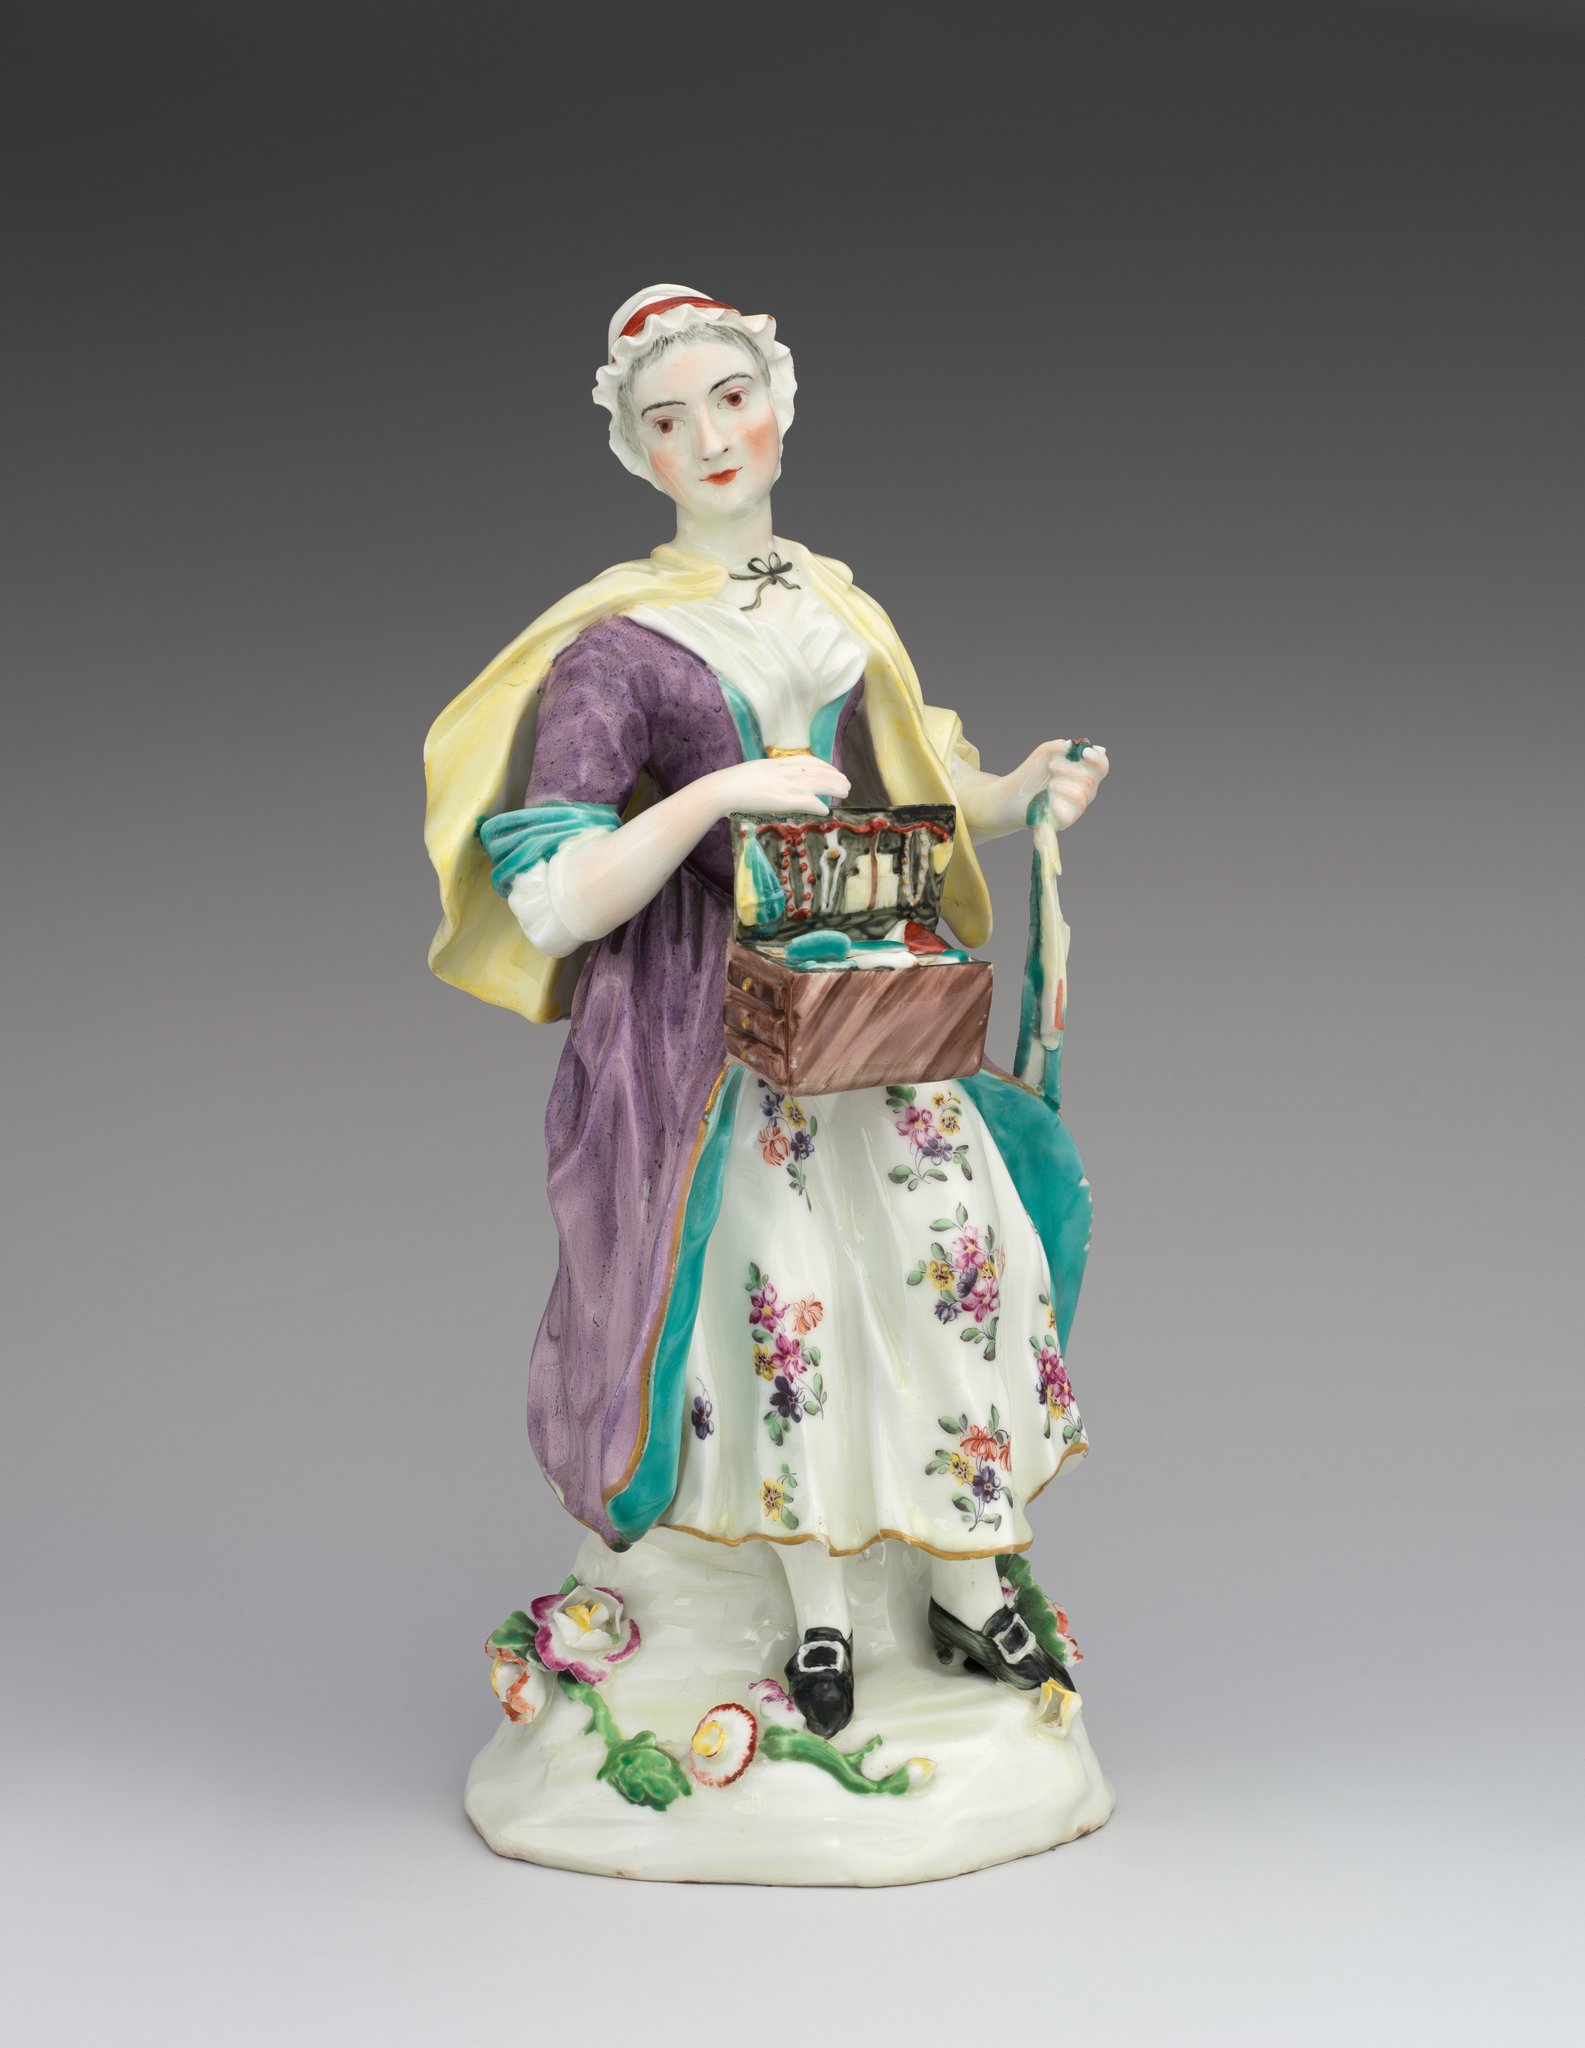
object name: figure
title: Pedlar (one of a pair)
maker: derby porcelain manufactory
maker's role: factory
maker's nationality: british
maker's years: 1751-1785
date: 1765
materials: soft paste porcelain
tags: women